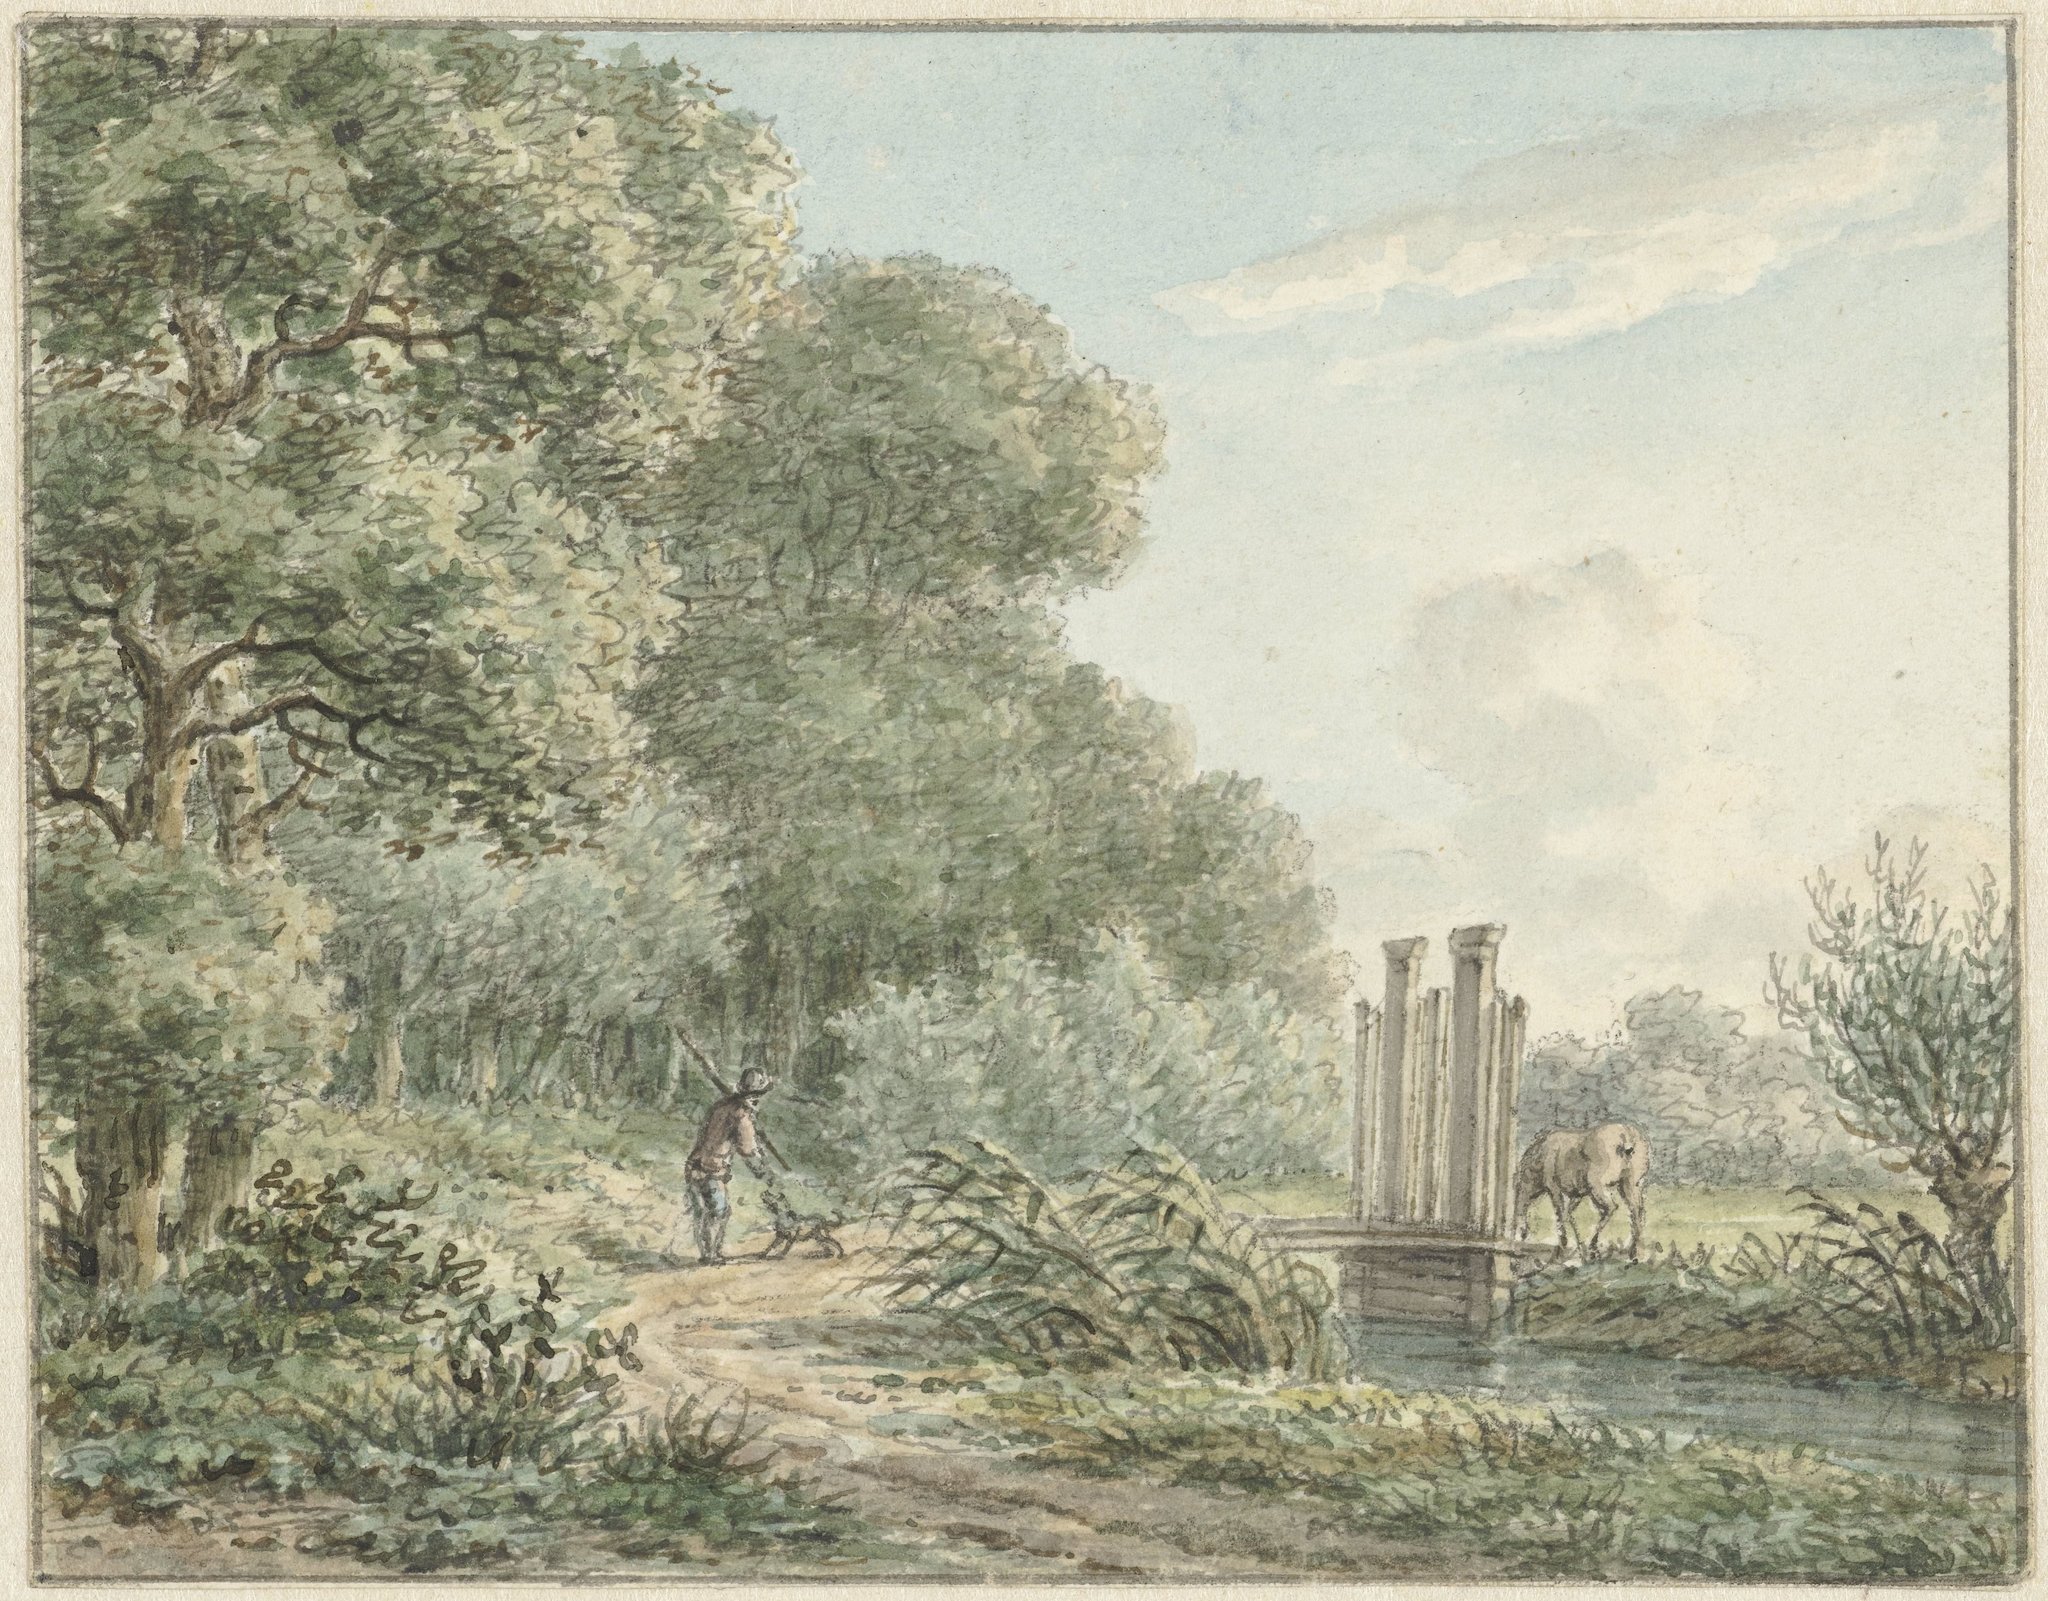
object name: drawing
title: Wandelaar op de Amstelveense Weg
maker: jan evert grave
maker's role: draughtsman, print maker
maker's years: 1759-1805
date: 1798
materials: chalk, ink, paper, watercolor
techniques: brush, pen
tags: forest, wood, amsterdam